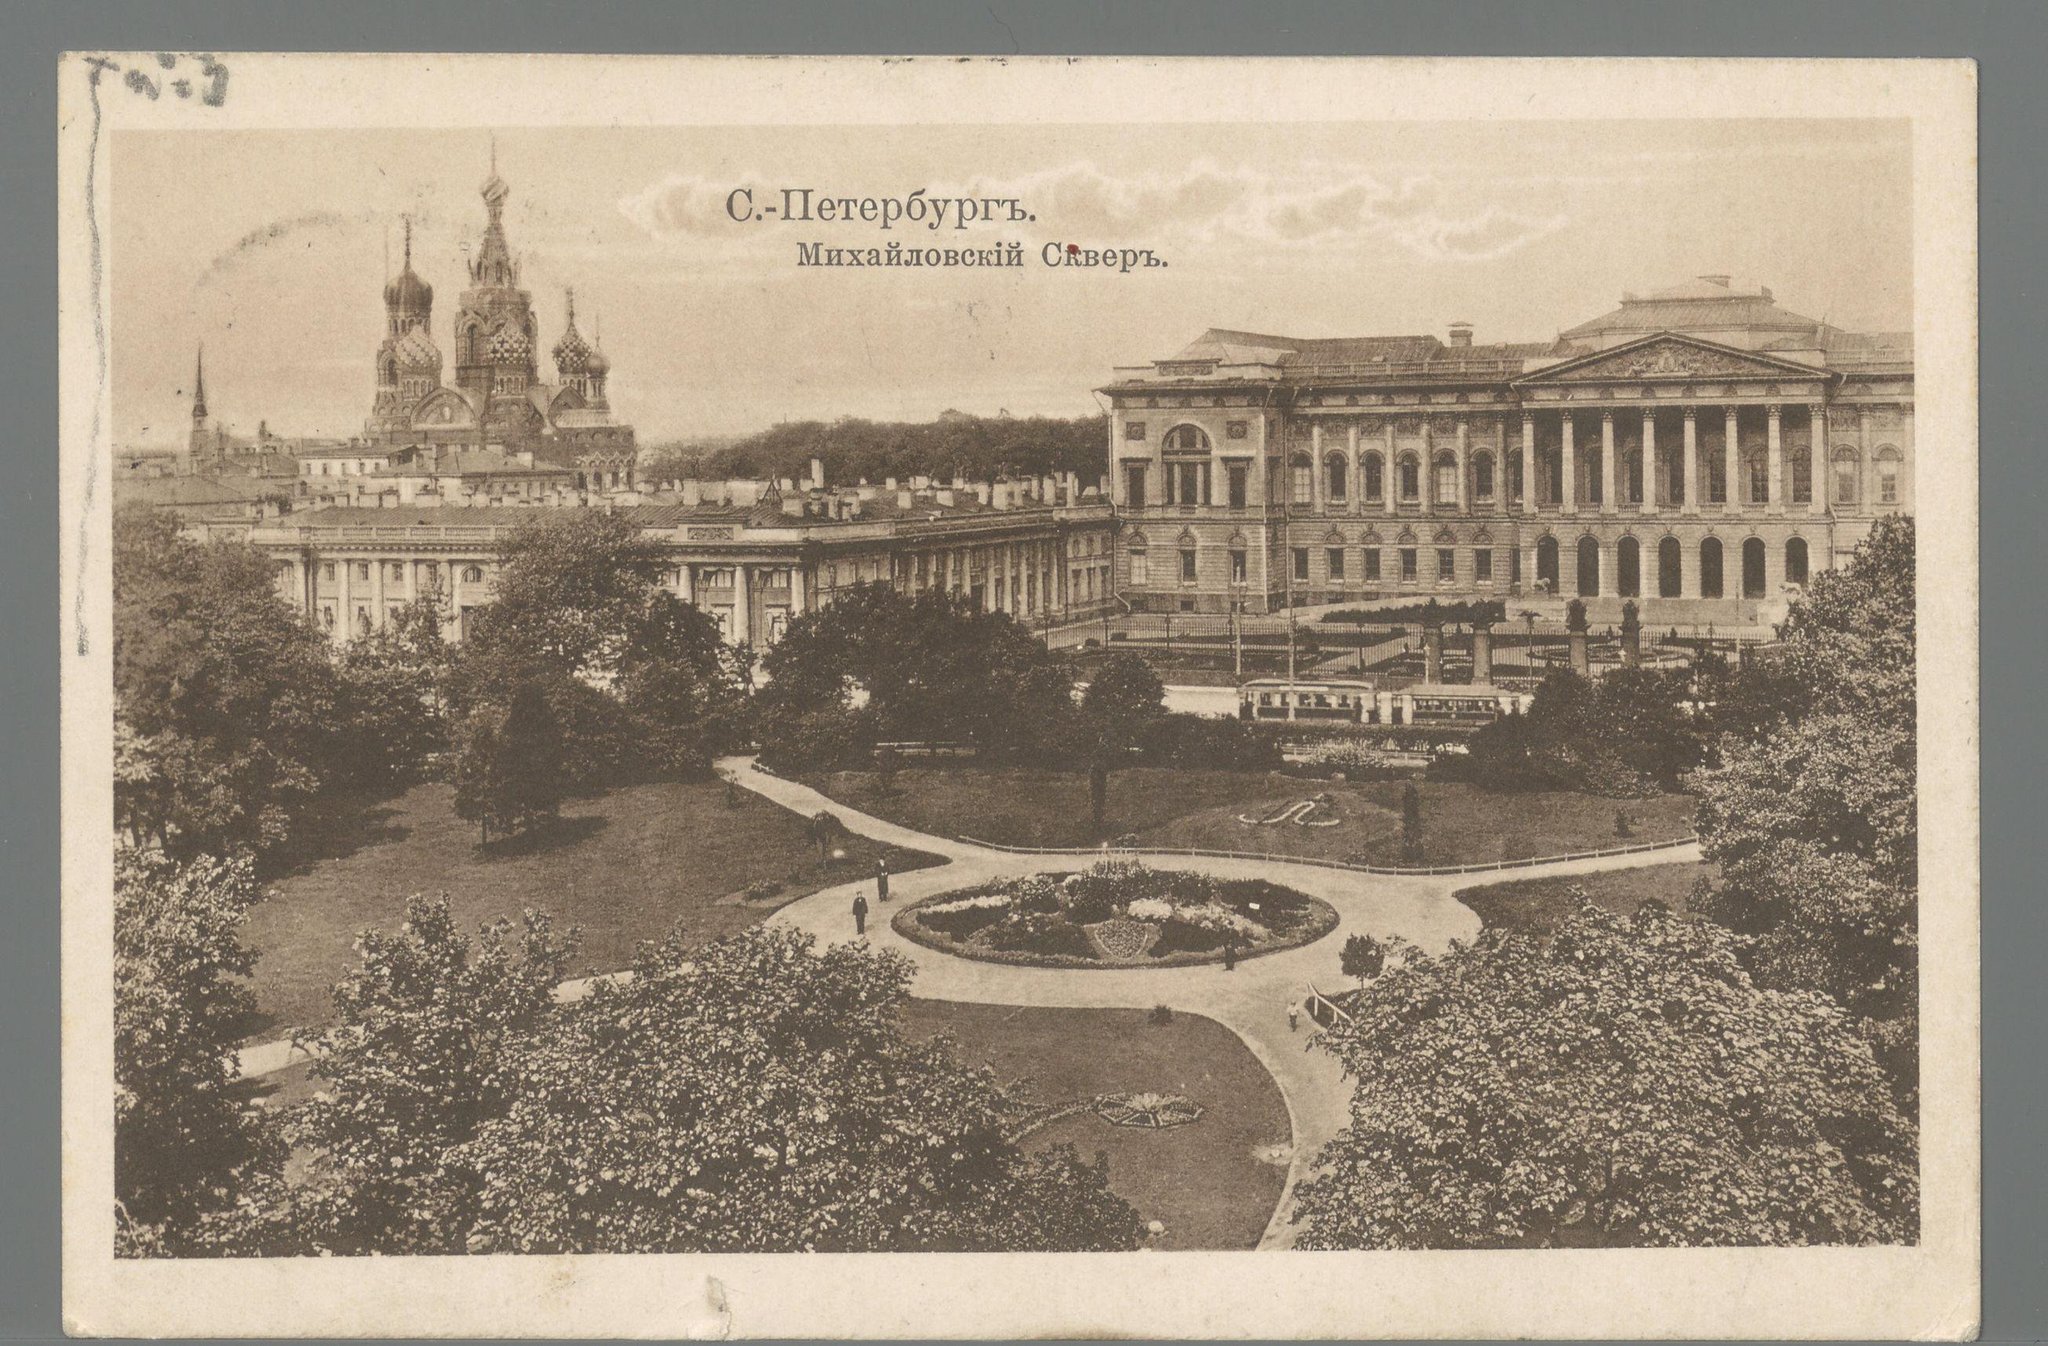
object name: photomechanical print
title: St. Pétersbourg. Place St. Michel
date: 1913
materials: cardboard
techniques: photograph, writing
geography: sint-petersburg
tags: square, place, circus, etc., palace, church (exterior)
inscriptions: postage stamp, inscription: ‘E.G.S.i.S.’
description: Op recto staat de titel in het Russisch.